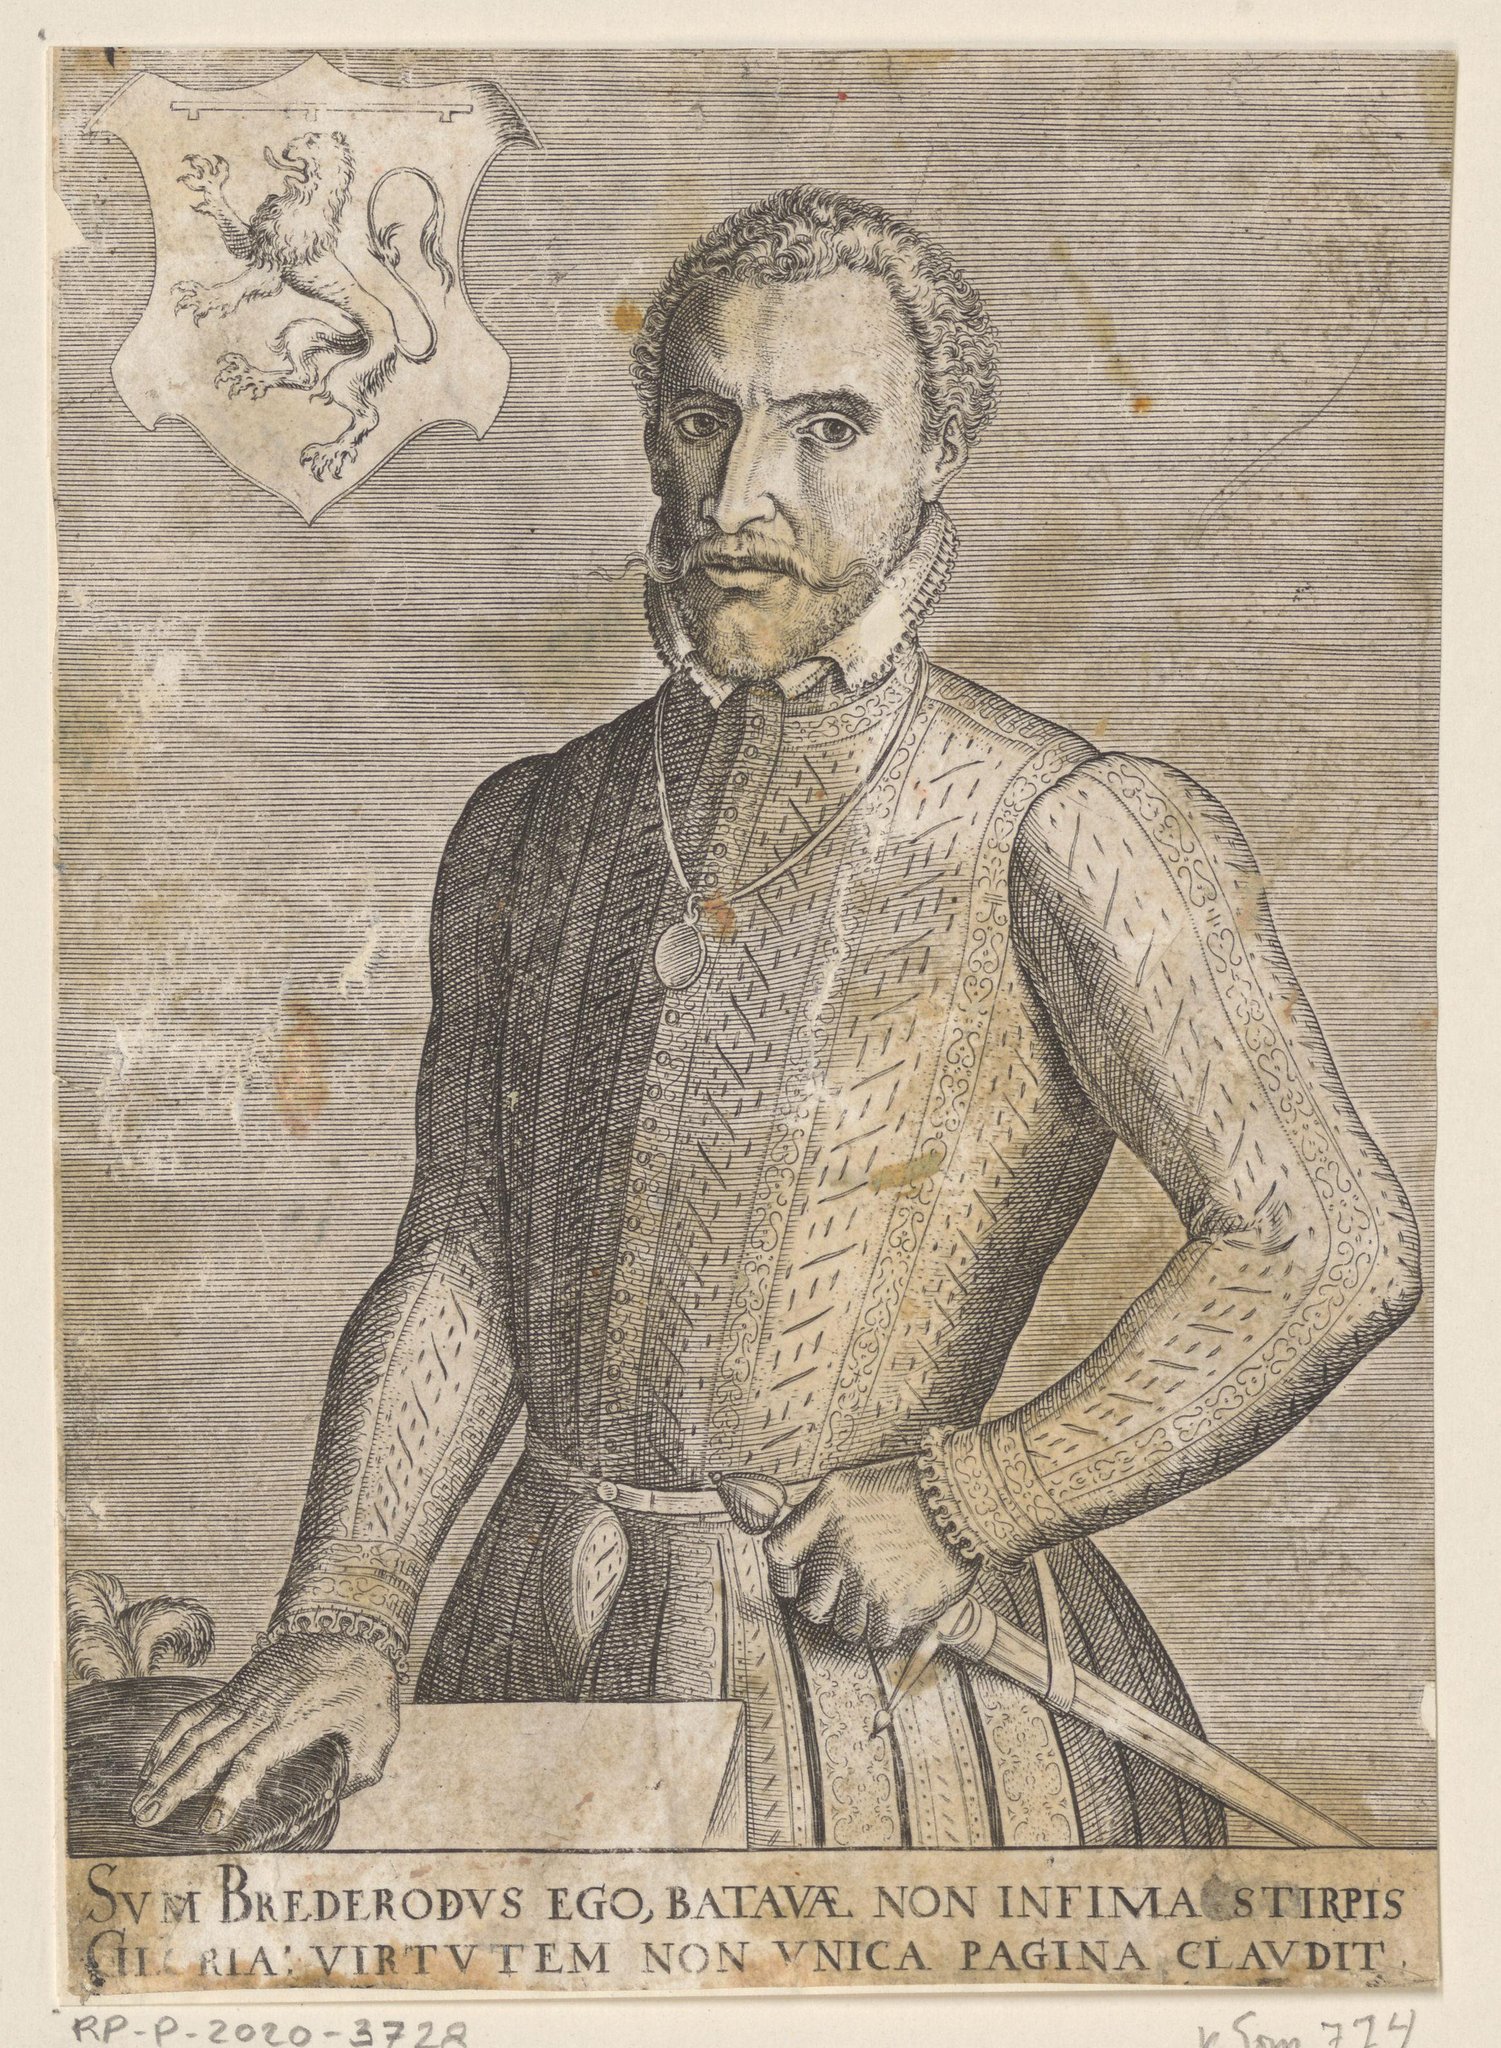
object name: print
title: Portret van Hendrik van Brederode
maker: hans liefrinck (i)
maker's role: print maker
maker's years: 1518-1573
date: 1538-1573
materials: paper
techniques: engraving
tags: armour, historical persons, hacking and thrusting weapons: sword